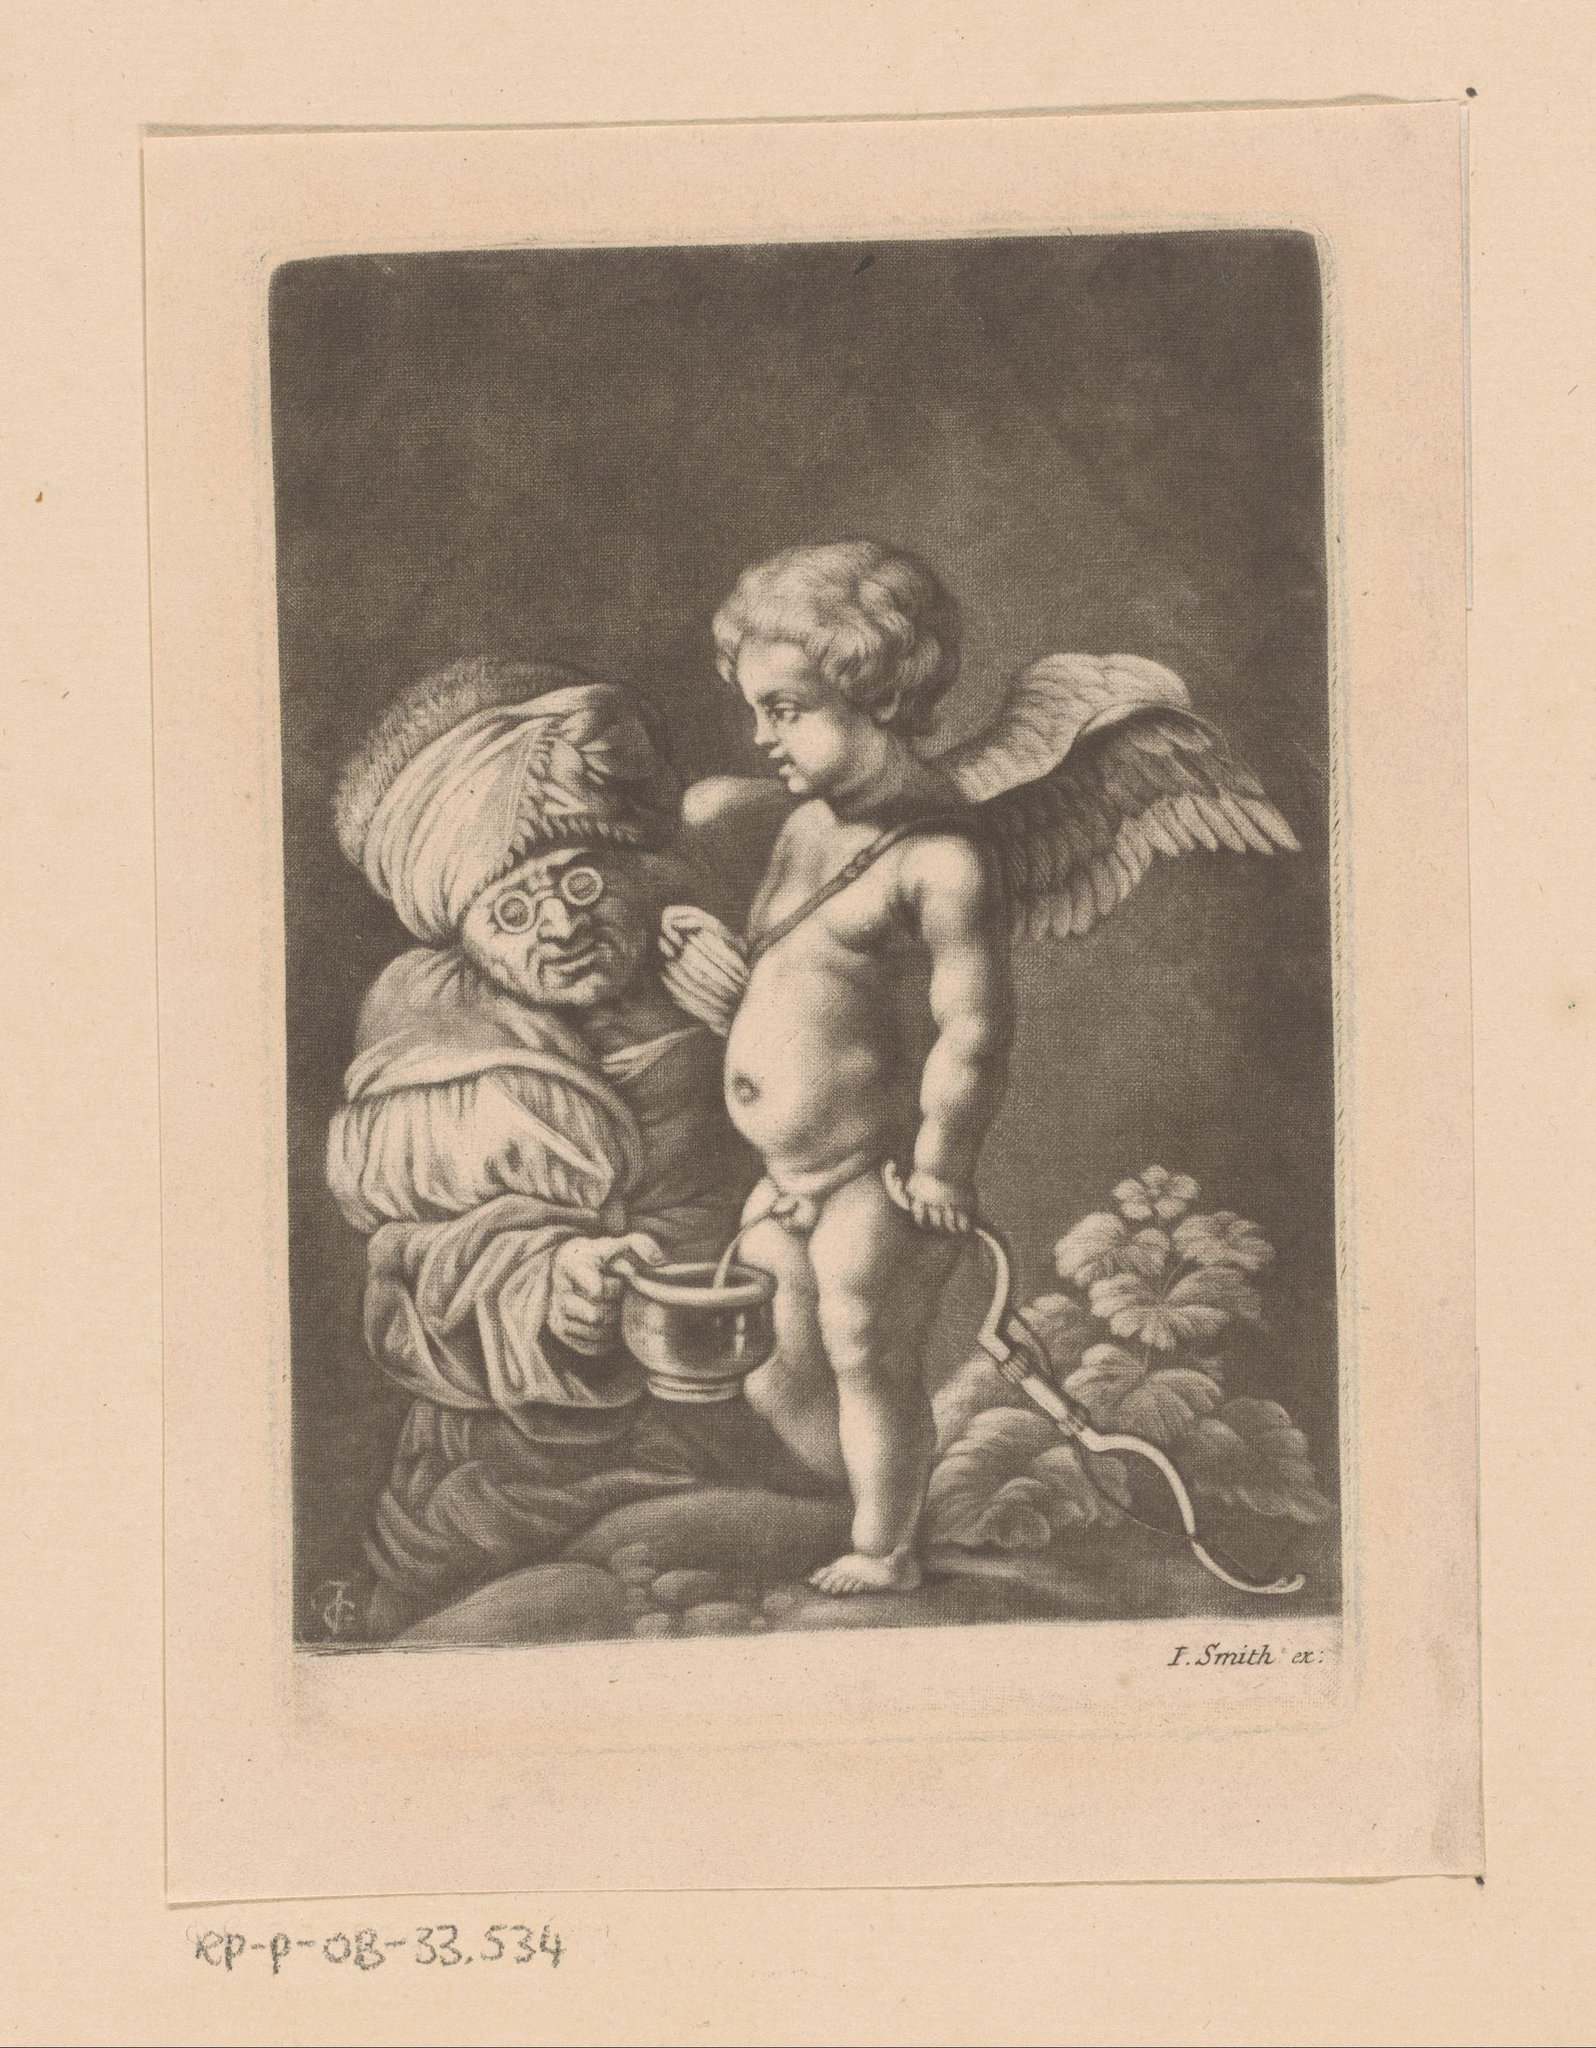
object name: print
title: Cupido plast in een pot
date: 1662-1742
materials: paper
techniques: mezzotint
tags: alchemist at work, urination, cupids: 'amores', 'amoretti', 'putti'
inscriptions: collector's mark: Lugt 240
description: De pot wordt opgehouden door een bebrild persoon, mogelijk een alchemist.